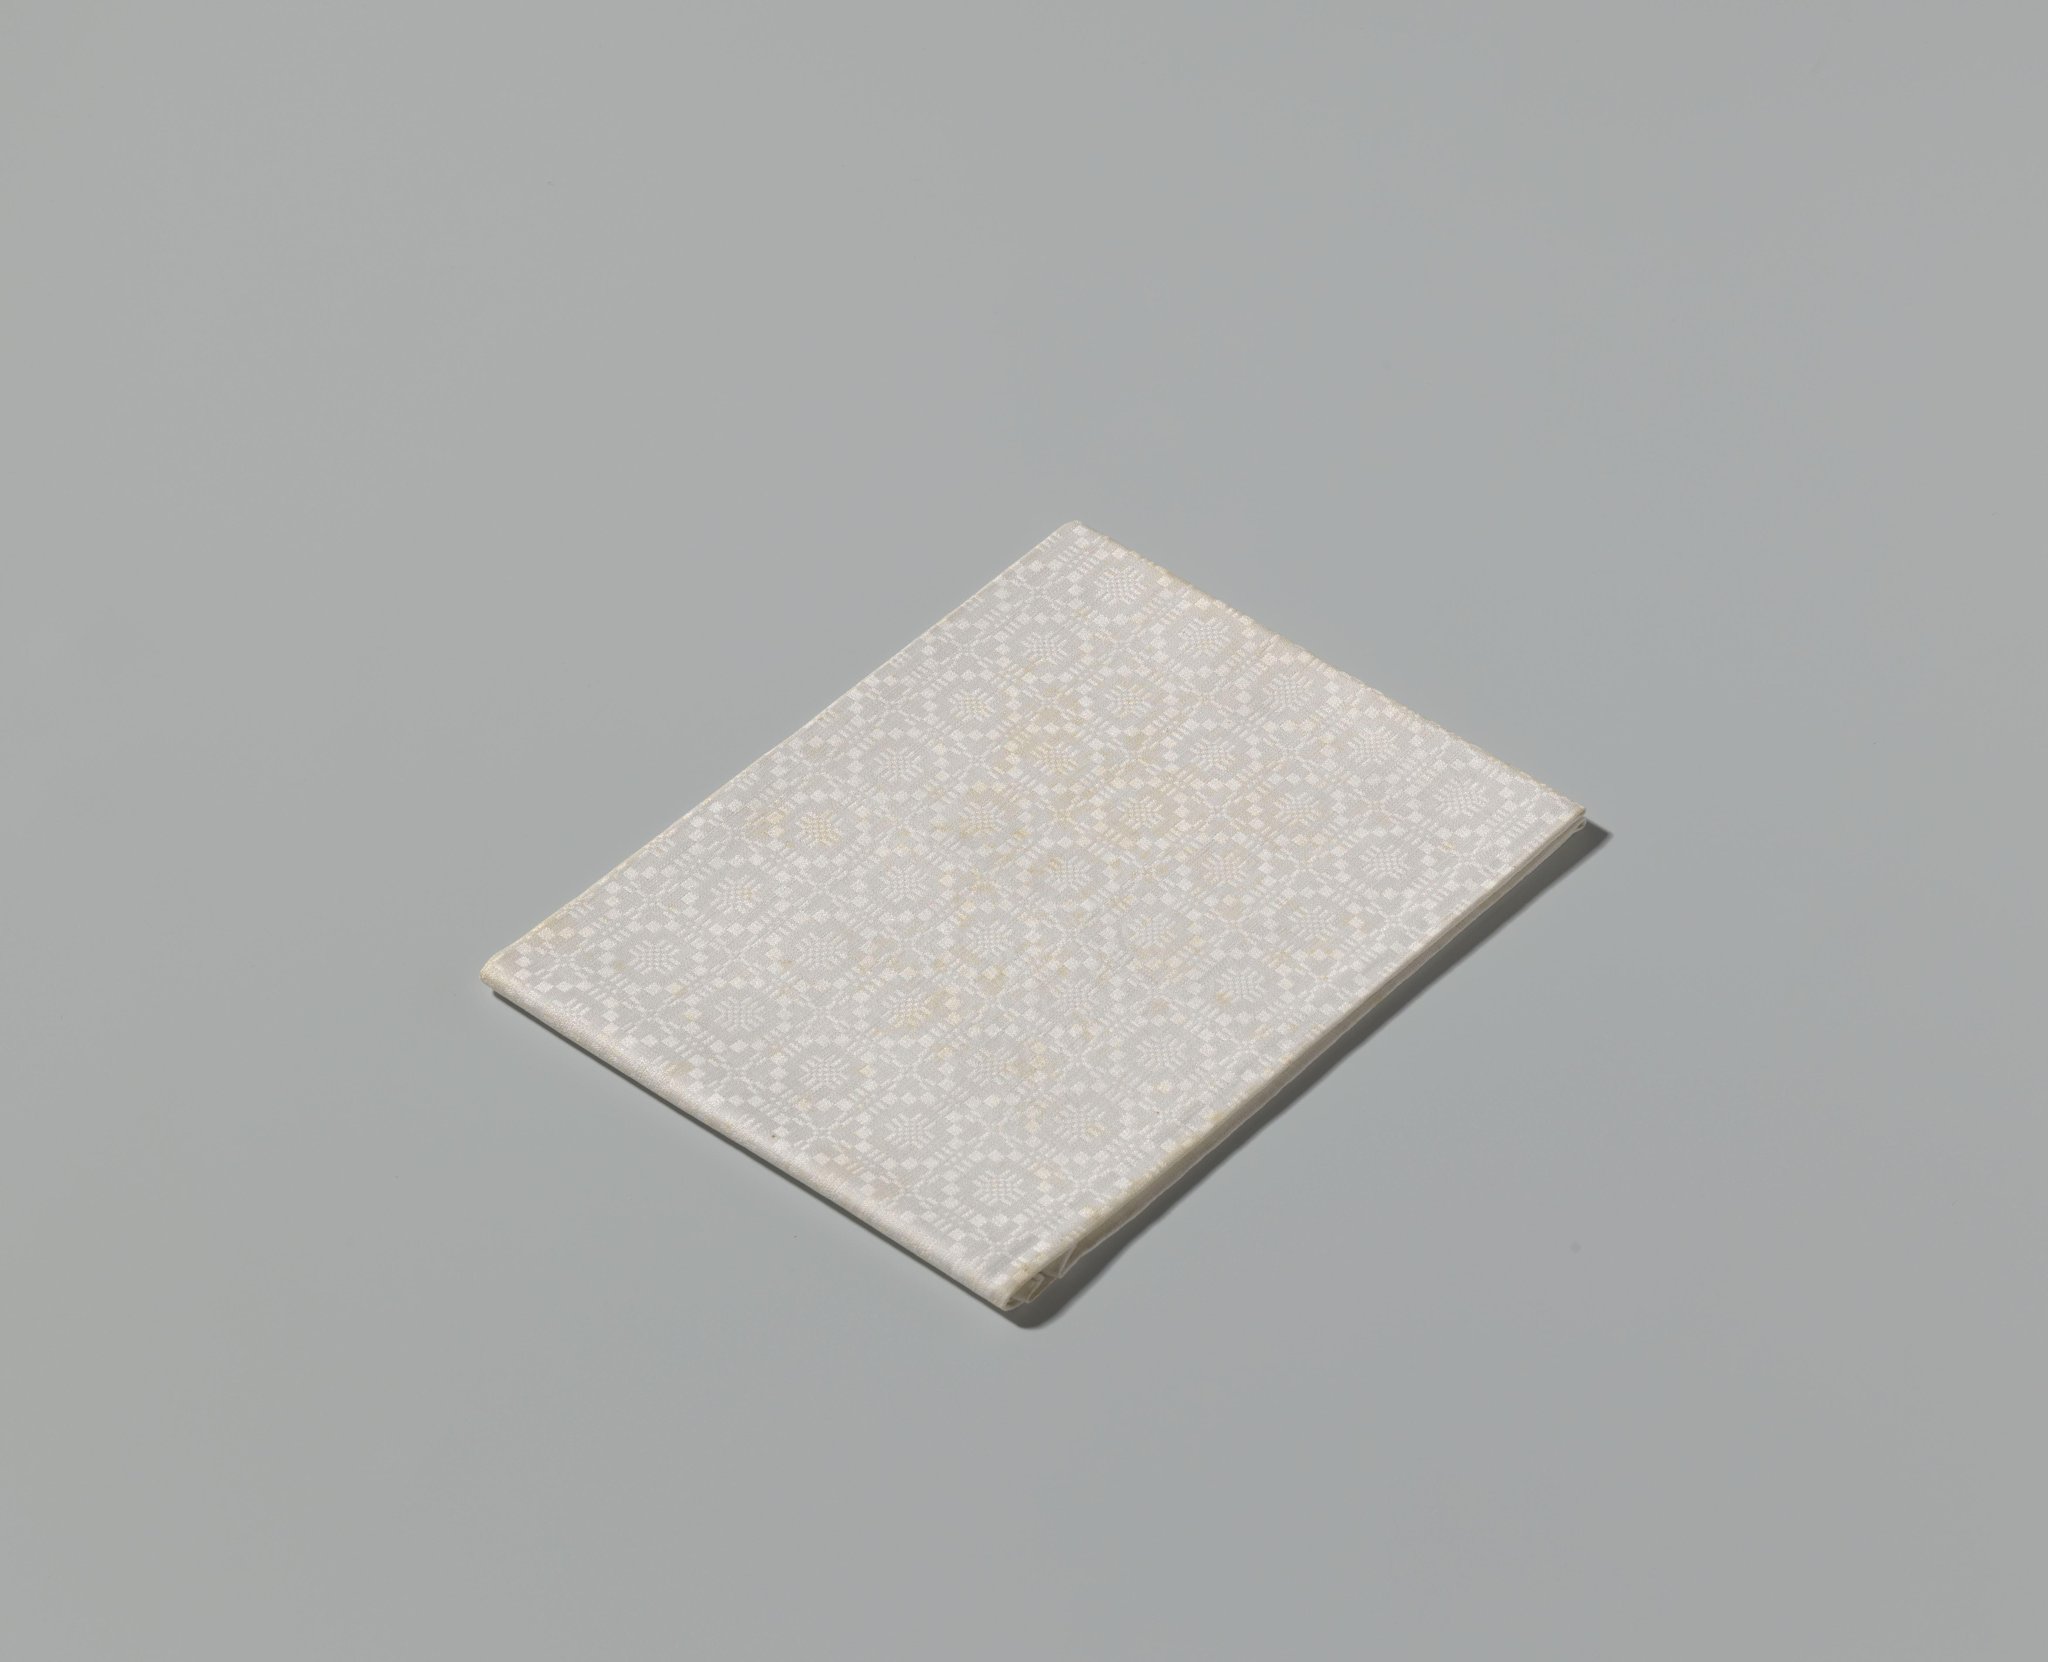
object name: napkin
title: Pellen. Merk: RR en WR(?) WH 200nl.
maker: Anonymous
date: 1600-1699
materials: linen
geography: netherlands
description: Servet van wit linnen met een pellen patroon, merk kroon RR en WR (?) WH 2oonl.